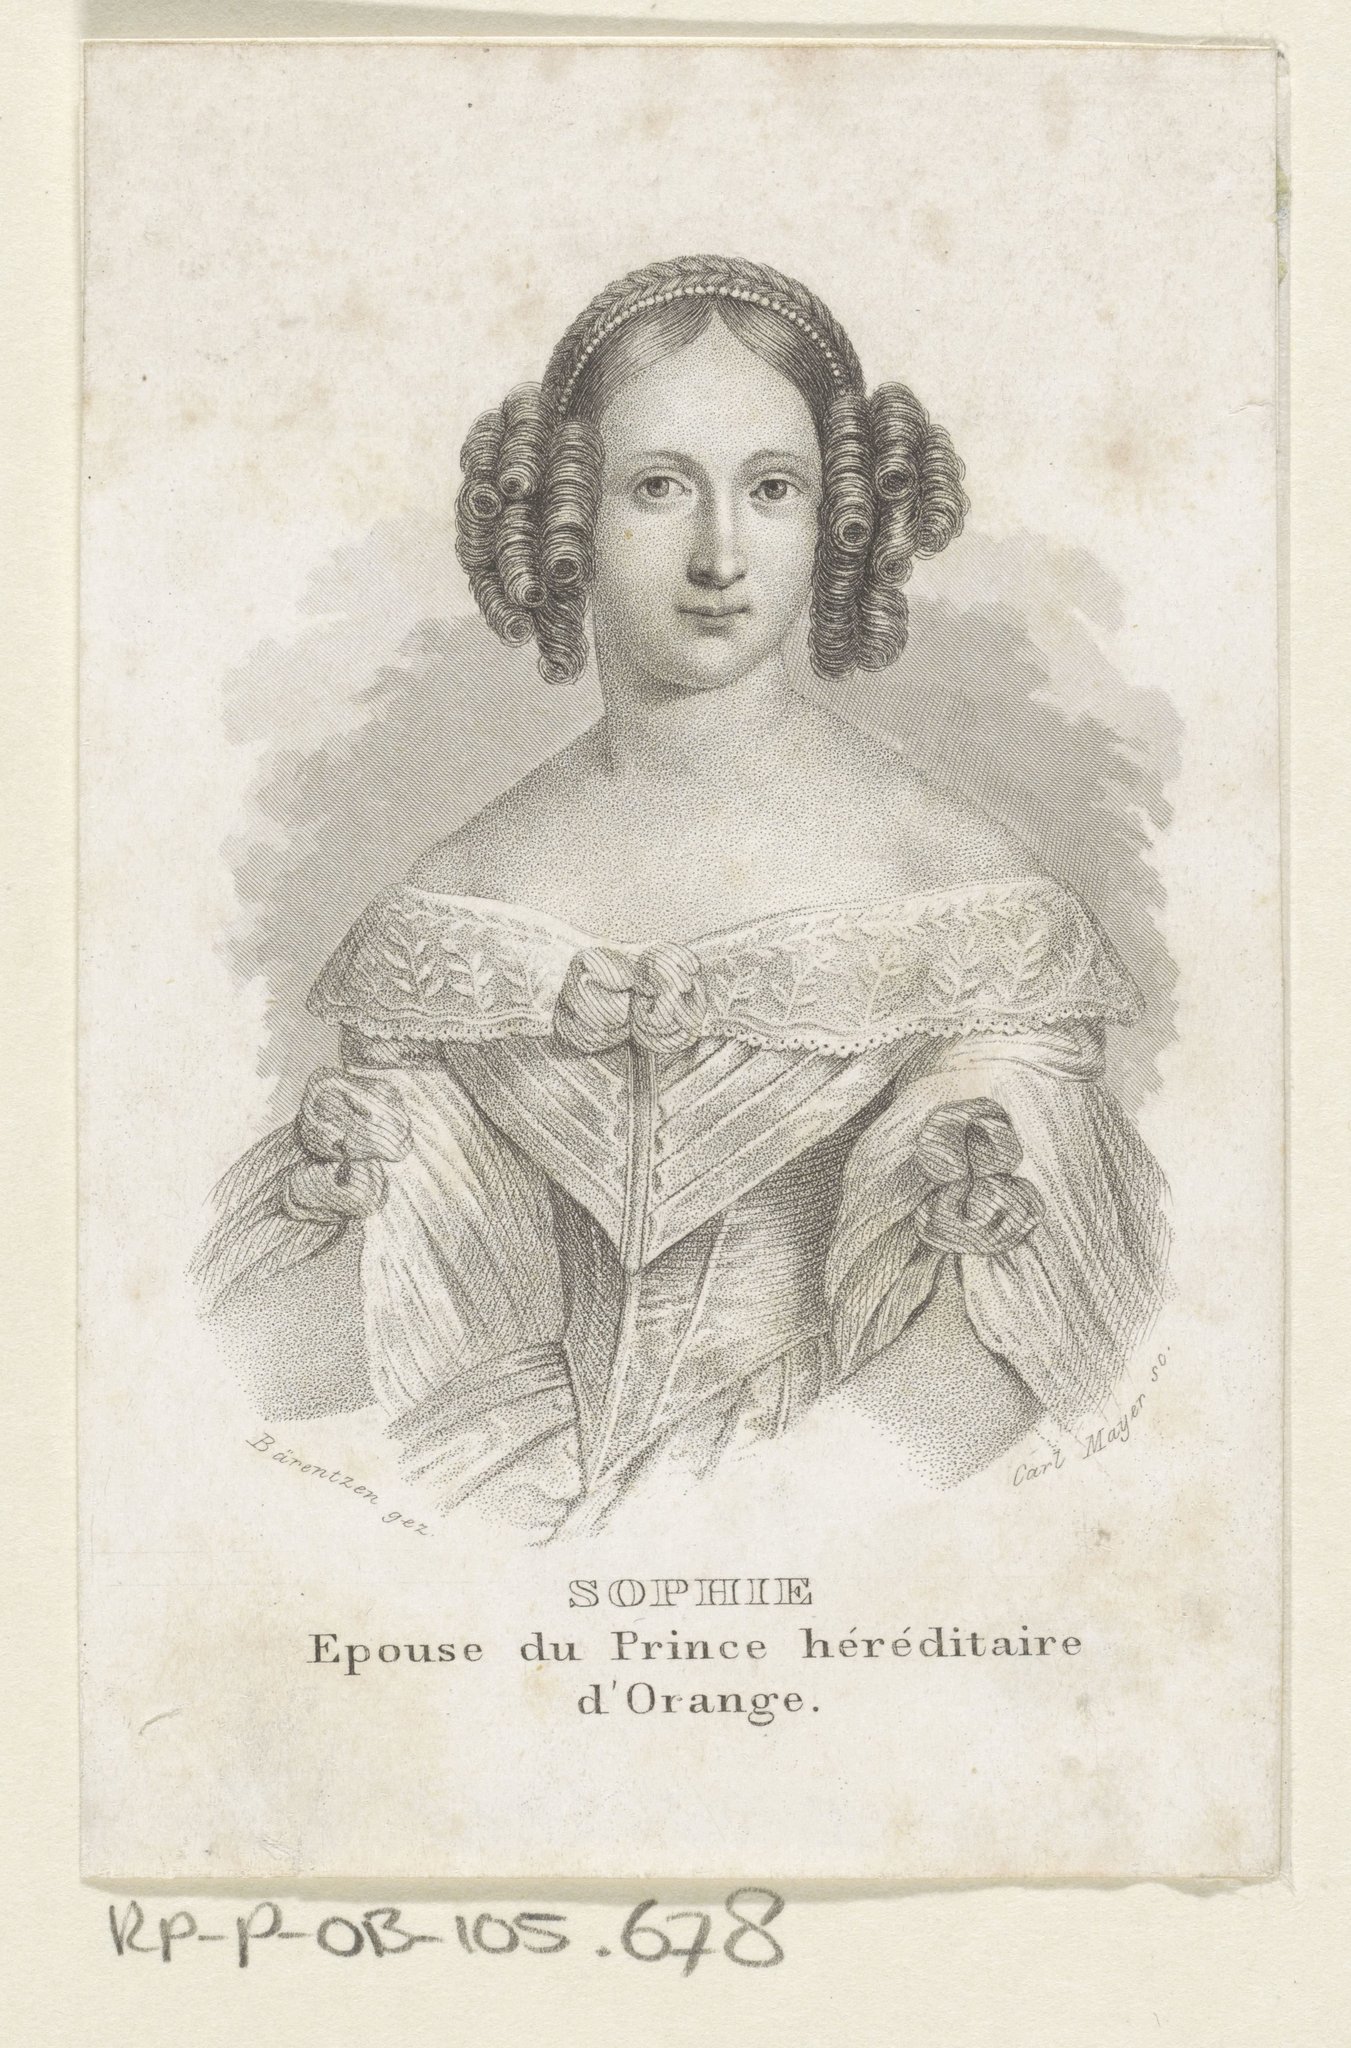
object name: print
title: Portret van Sophie van Württemberg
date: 1839-1868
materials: paper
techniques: engraving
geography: nuremberg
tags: the hague, sophia frederika mathilda van württemberg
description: Portret van Sophie. In de ondermarge haar naam en titel in het Frans.